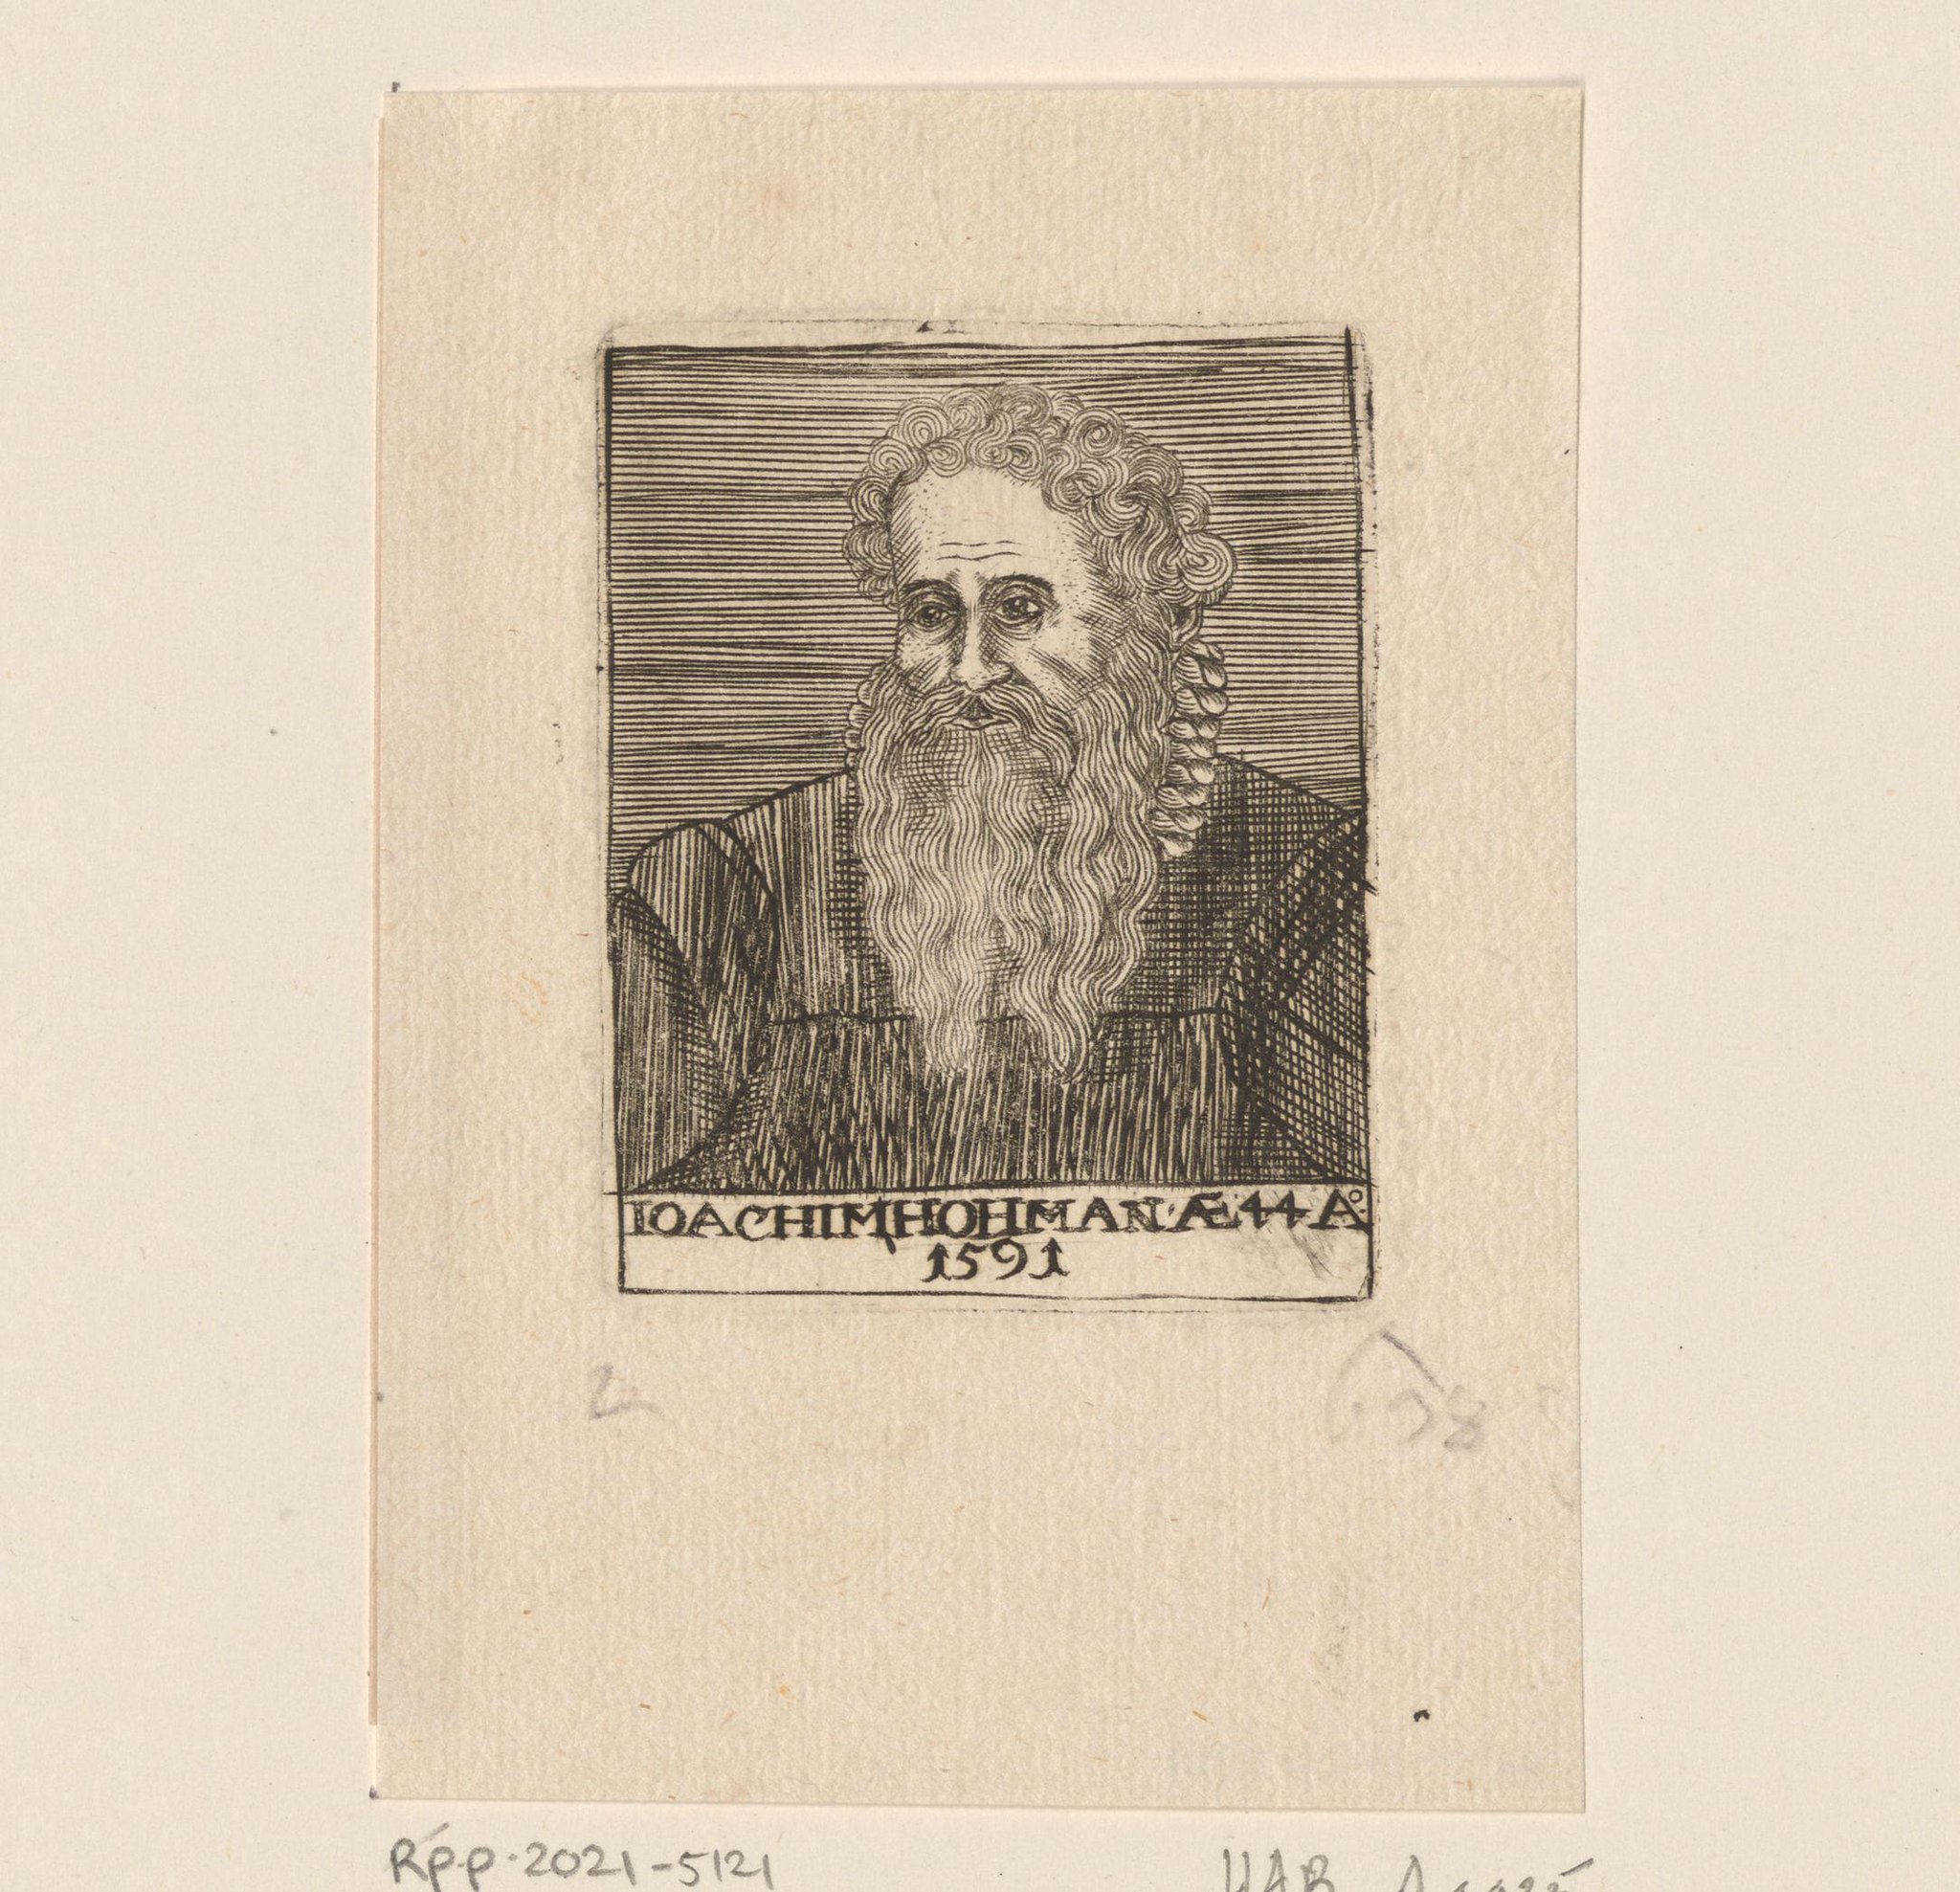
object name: print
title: Portret van Joachim Hohmann op 44-jarige leeftijd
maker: Anonymous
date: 1591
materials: paper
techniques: engraving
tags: adult man, historical persons, physician, doctor